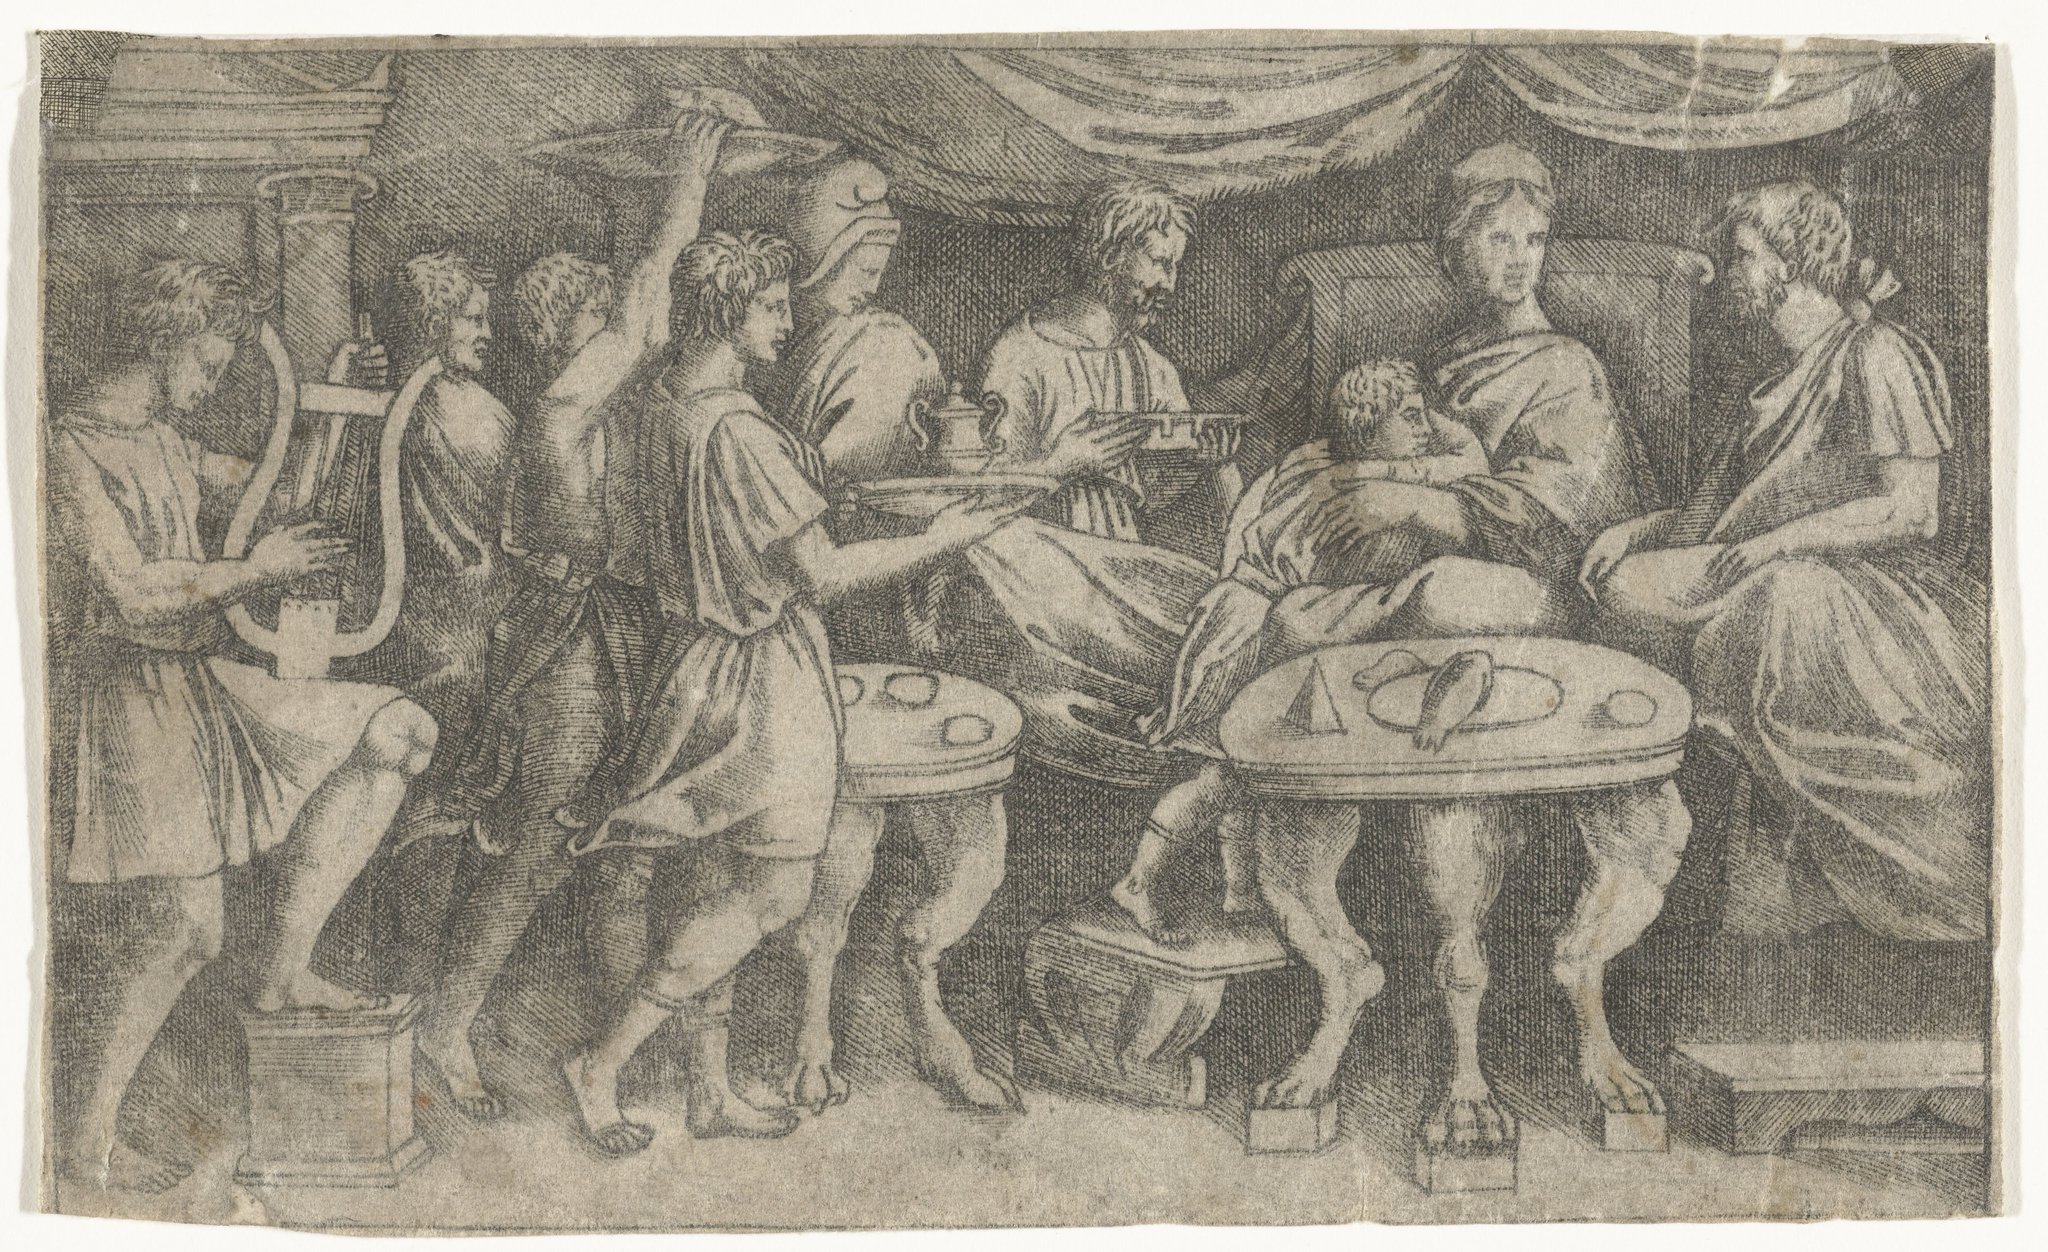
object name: print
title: Feestmaal van Dido en Aeneas en Cupido vermomd als Ascanius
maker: Anonymous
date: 1515-1566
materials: paper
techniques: engraving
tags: (story of) dido, the story of aeneas' wanderings to italy (virgil, aeneid), venus gives cupid the form and features of ascanius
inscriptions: collector's mark: Lugt 240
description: Kopie in spiegelbeeld naar prent van Marcantonio Raimondi. Raimondi baseerde zich op een ontwerp van Raphael.